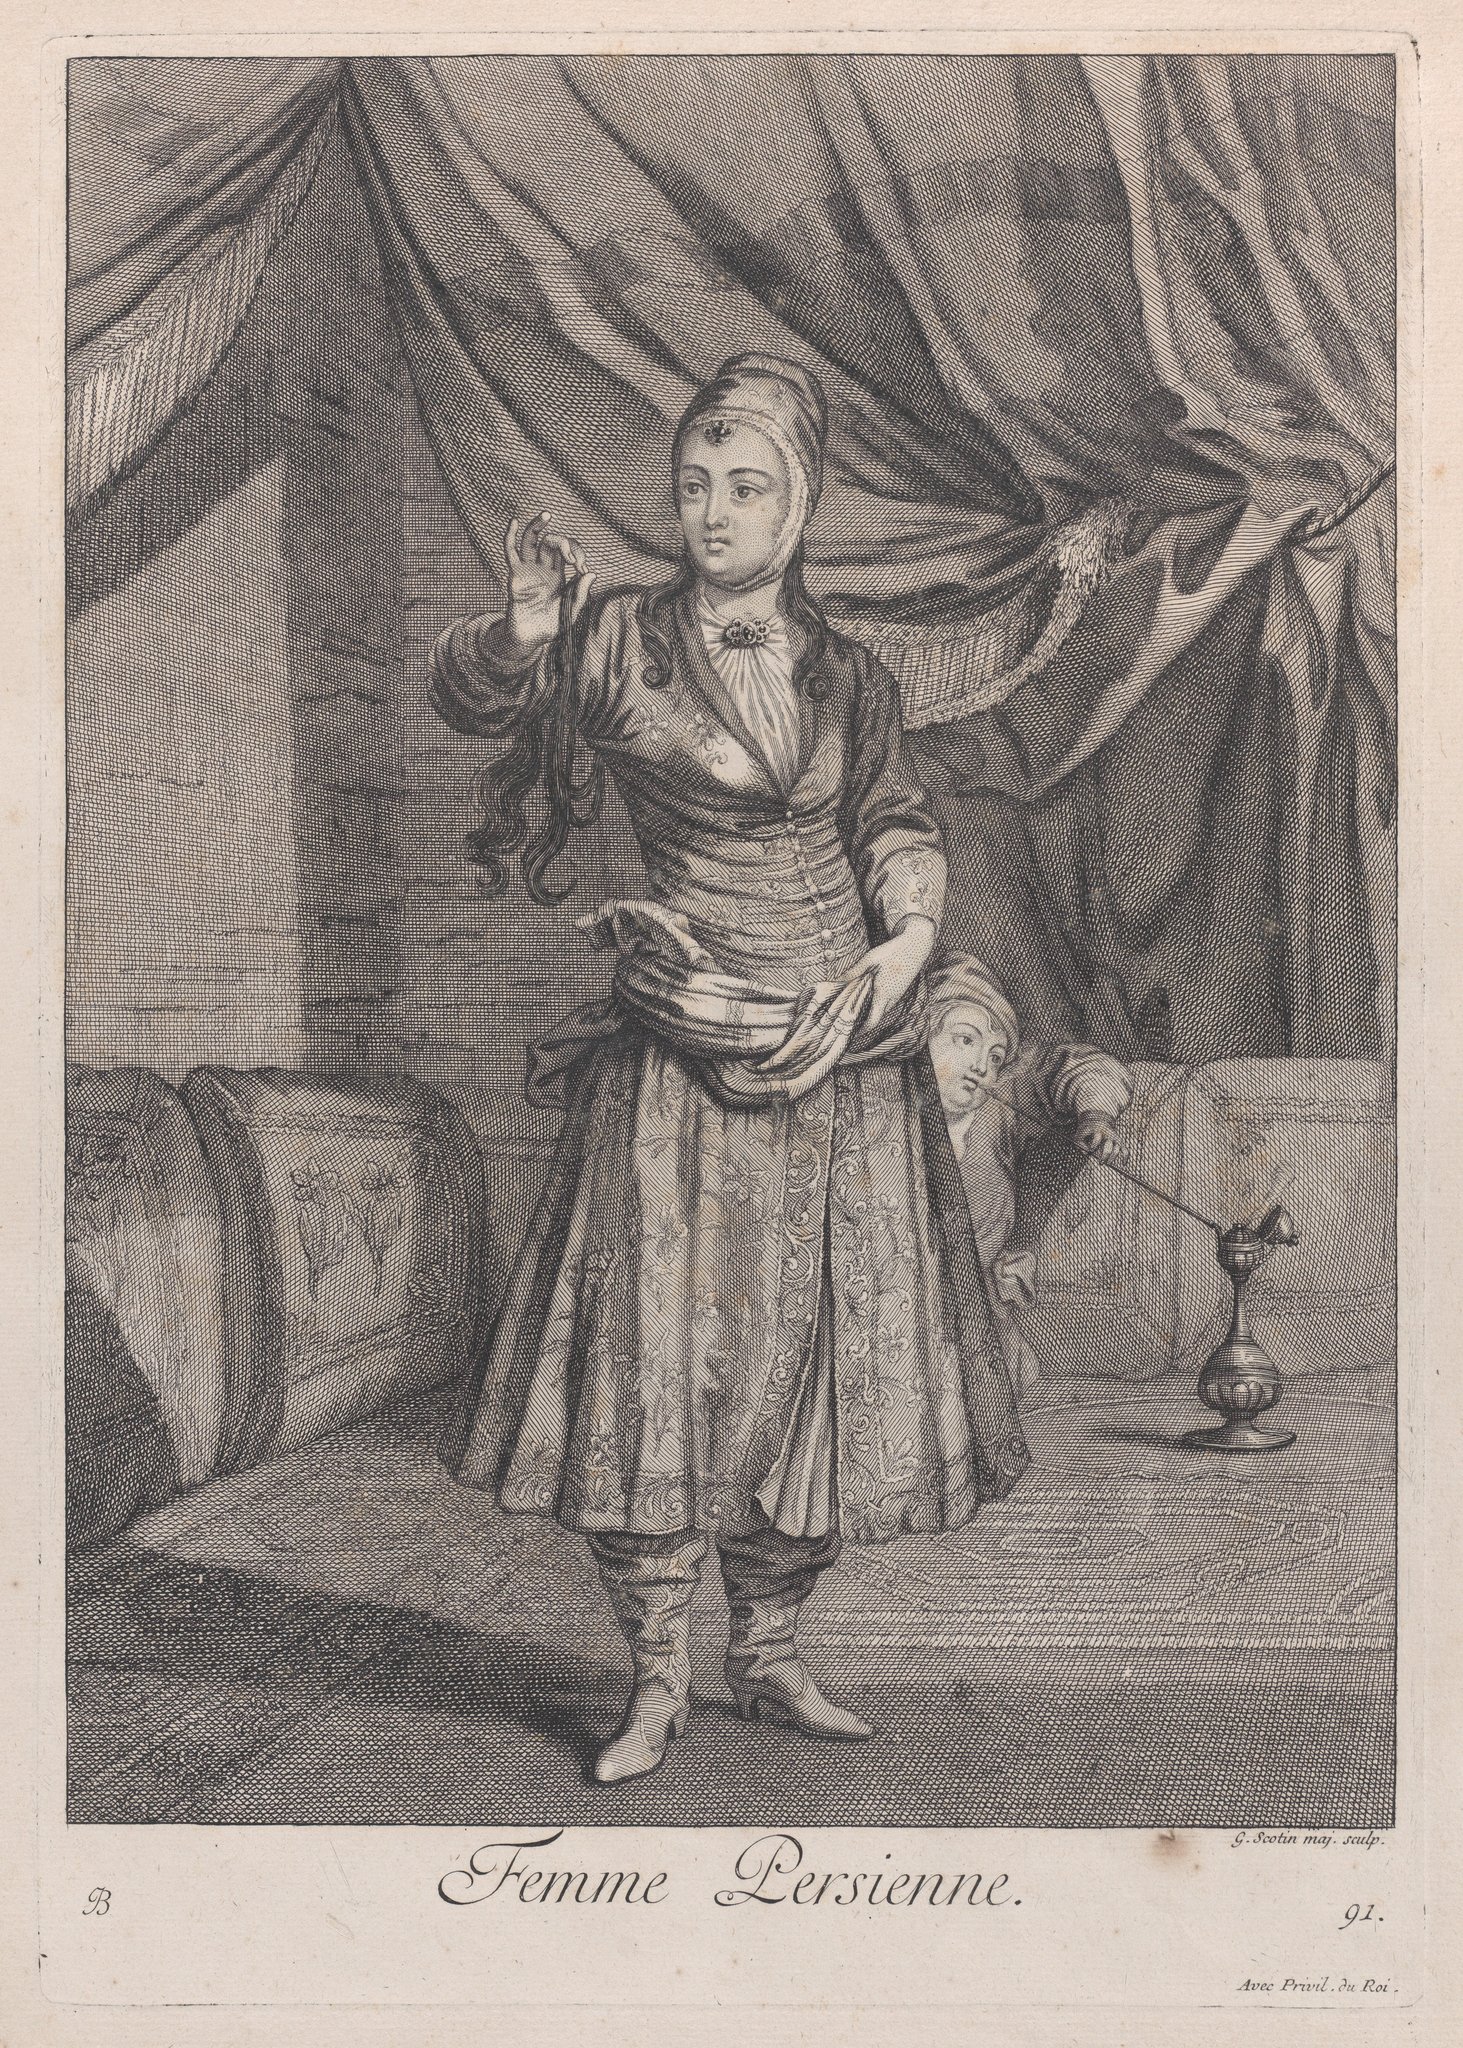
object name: print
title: Femme Persienne, plate 91 from "Recueil de cent estampes représentent differentes nations du Levant"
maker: jean baptiste vanmour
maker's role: artist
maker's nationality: french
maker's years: 1671-1737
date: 1714-1715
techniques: engraving, etching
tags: women